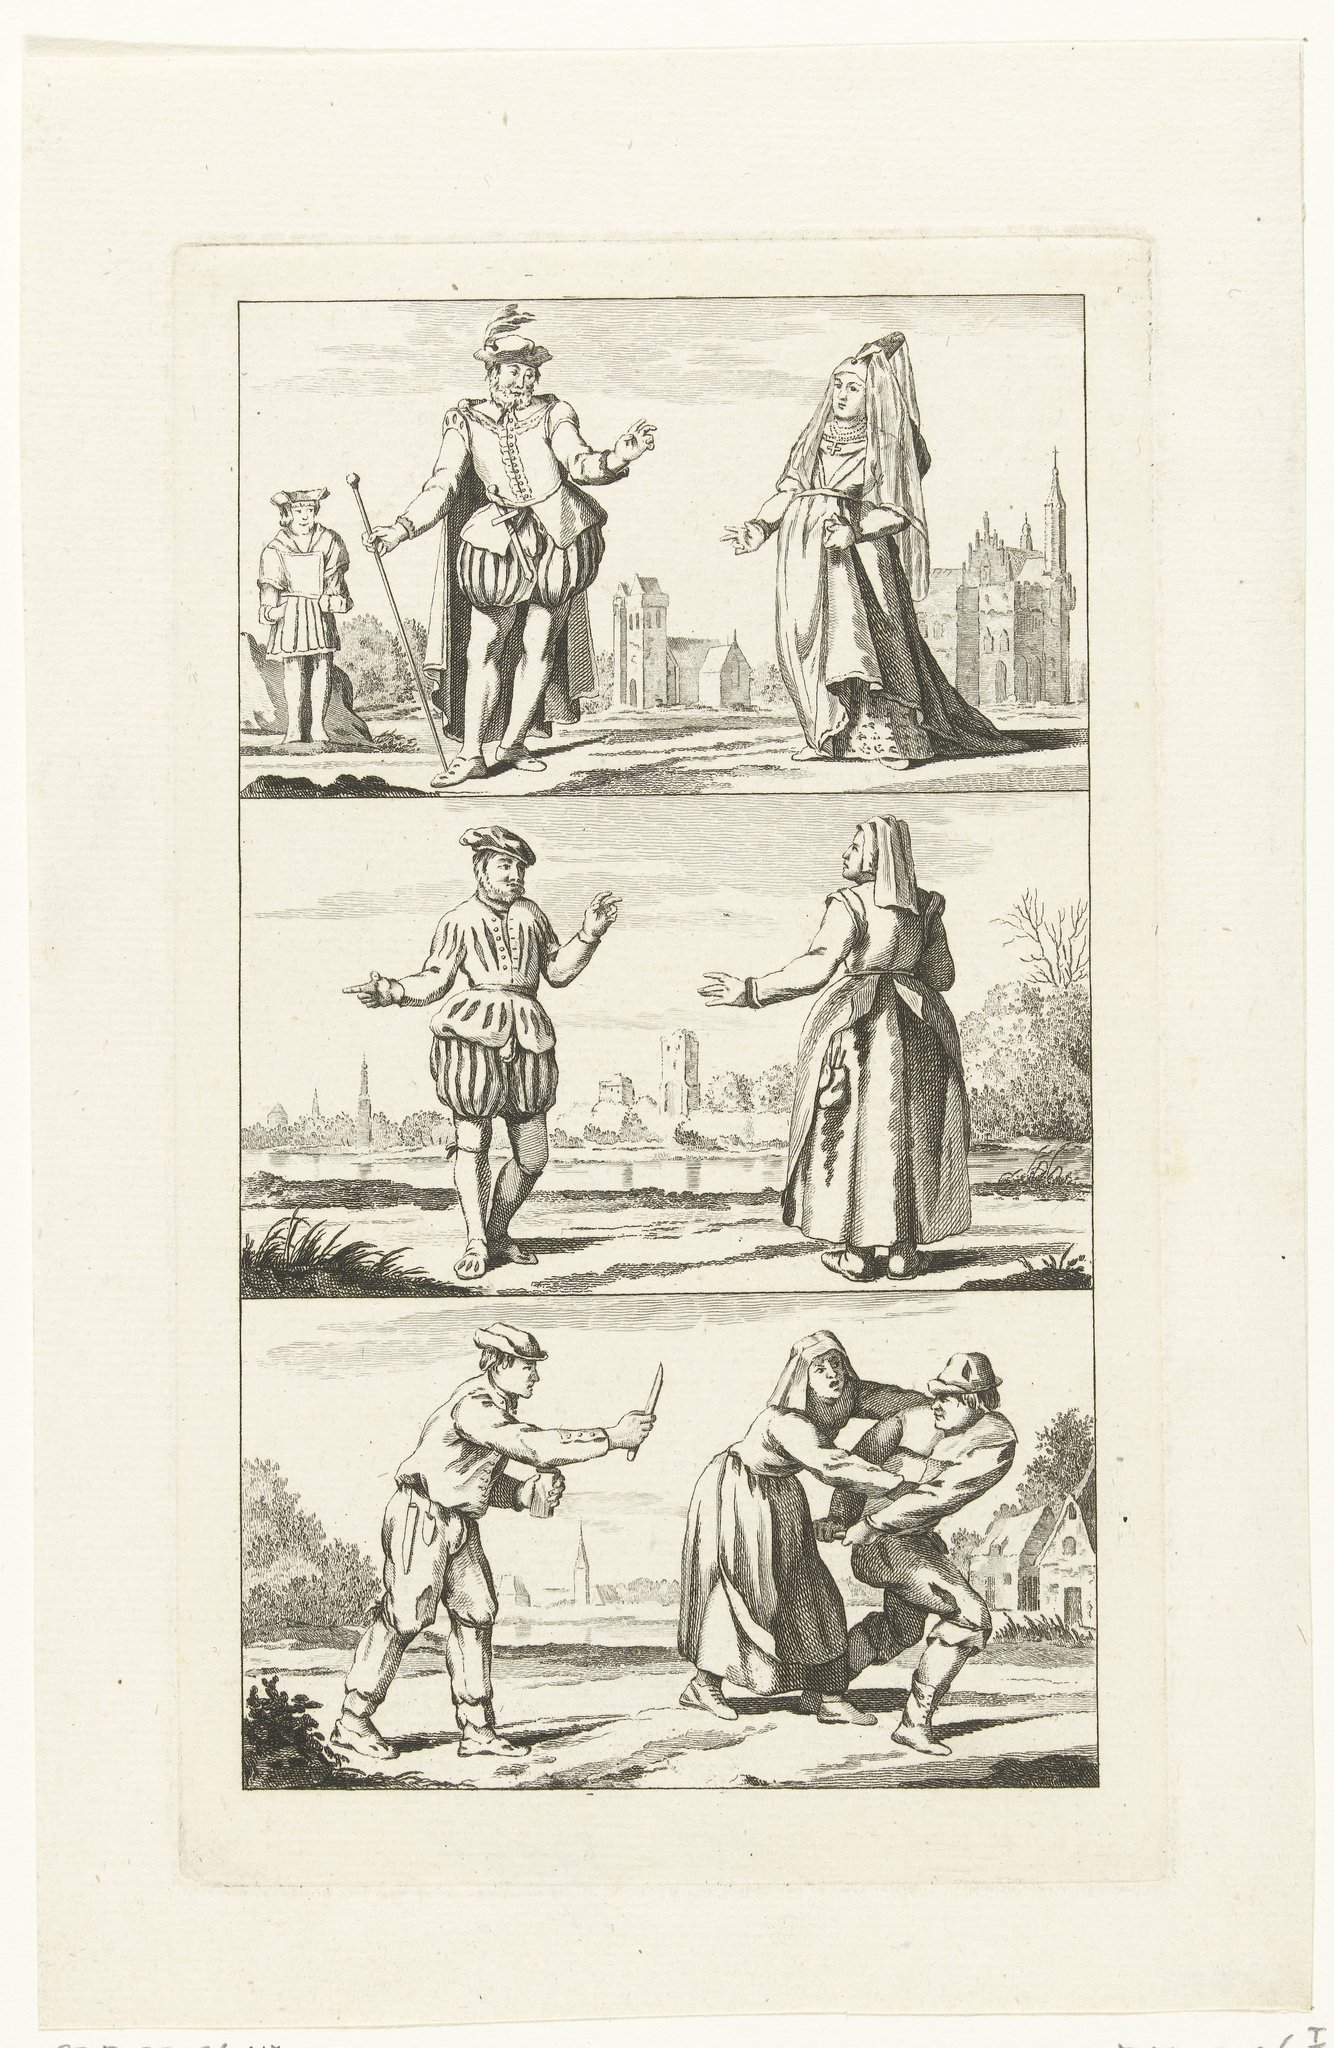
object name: costume print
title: Drie landschappen met mannen en vrouwen in Hollandse klederdrachten, ca. 1775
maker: cornelis brouwer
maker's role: print maker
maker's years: 1731-1803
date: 1776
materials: paper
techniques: etching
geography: netherlands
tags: folk costume, regional costume, europeans (with name)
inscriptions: collector's mark: Lugt 2228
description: Prent later gebruikt voor: J. Le Francq van Berkhey, Natuurlyke historie van Holland, 4 delen, Amsterdam, uitgever Yntema and Tieboel, 1769-1779, deel III, 1776, p. 494-796.